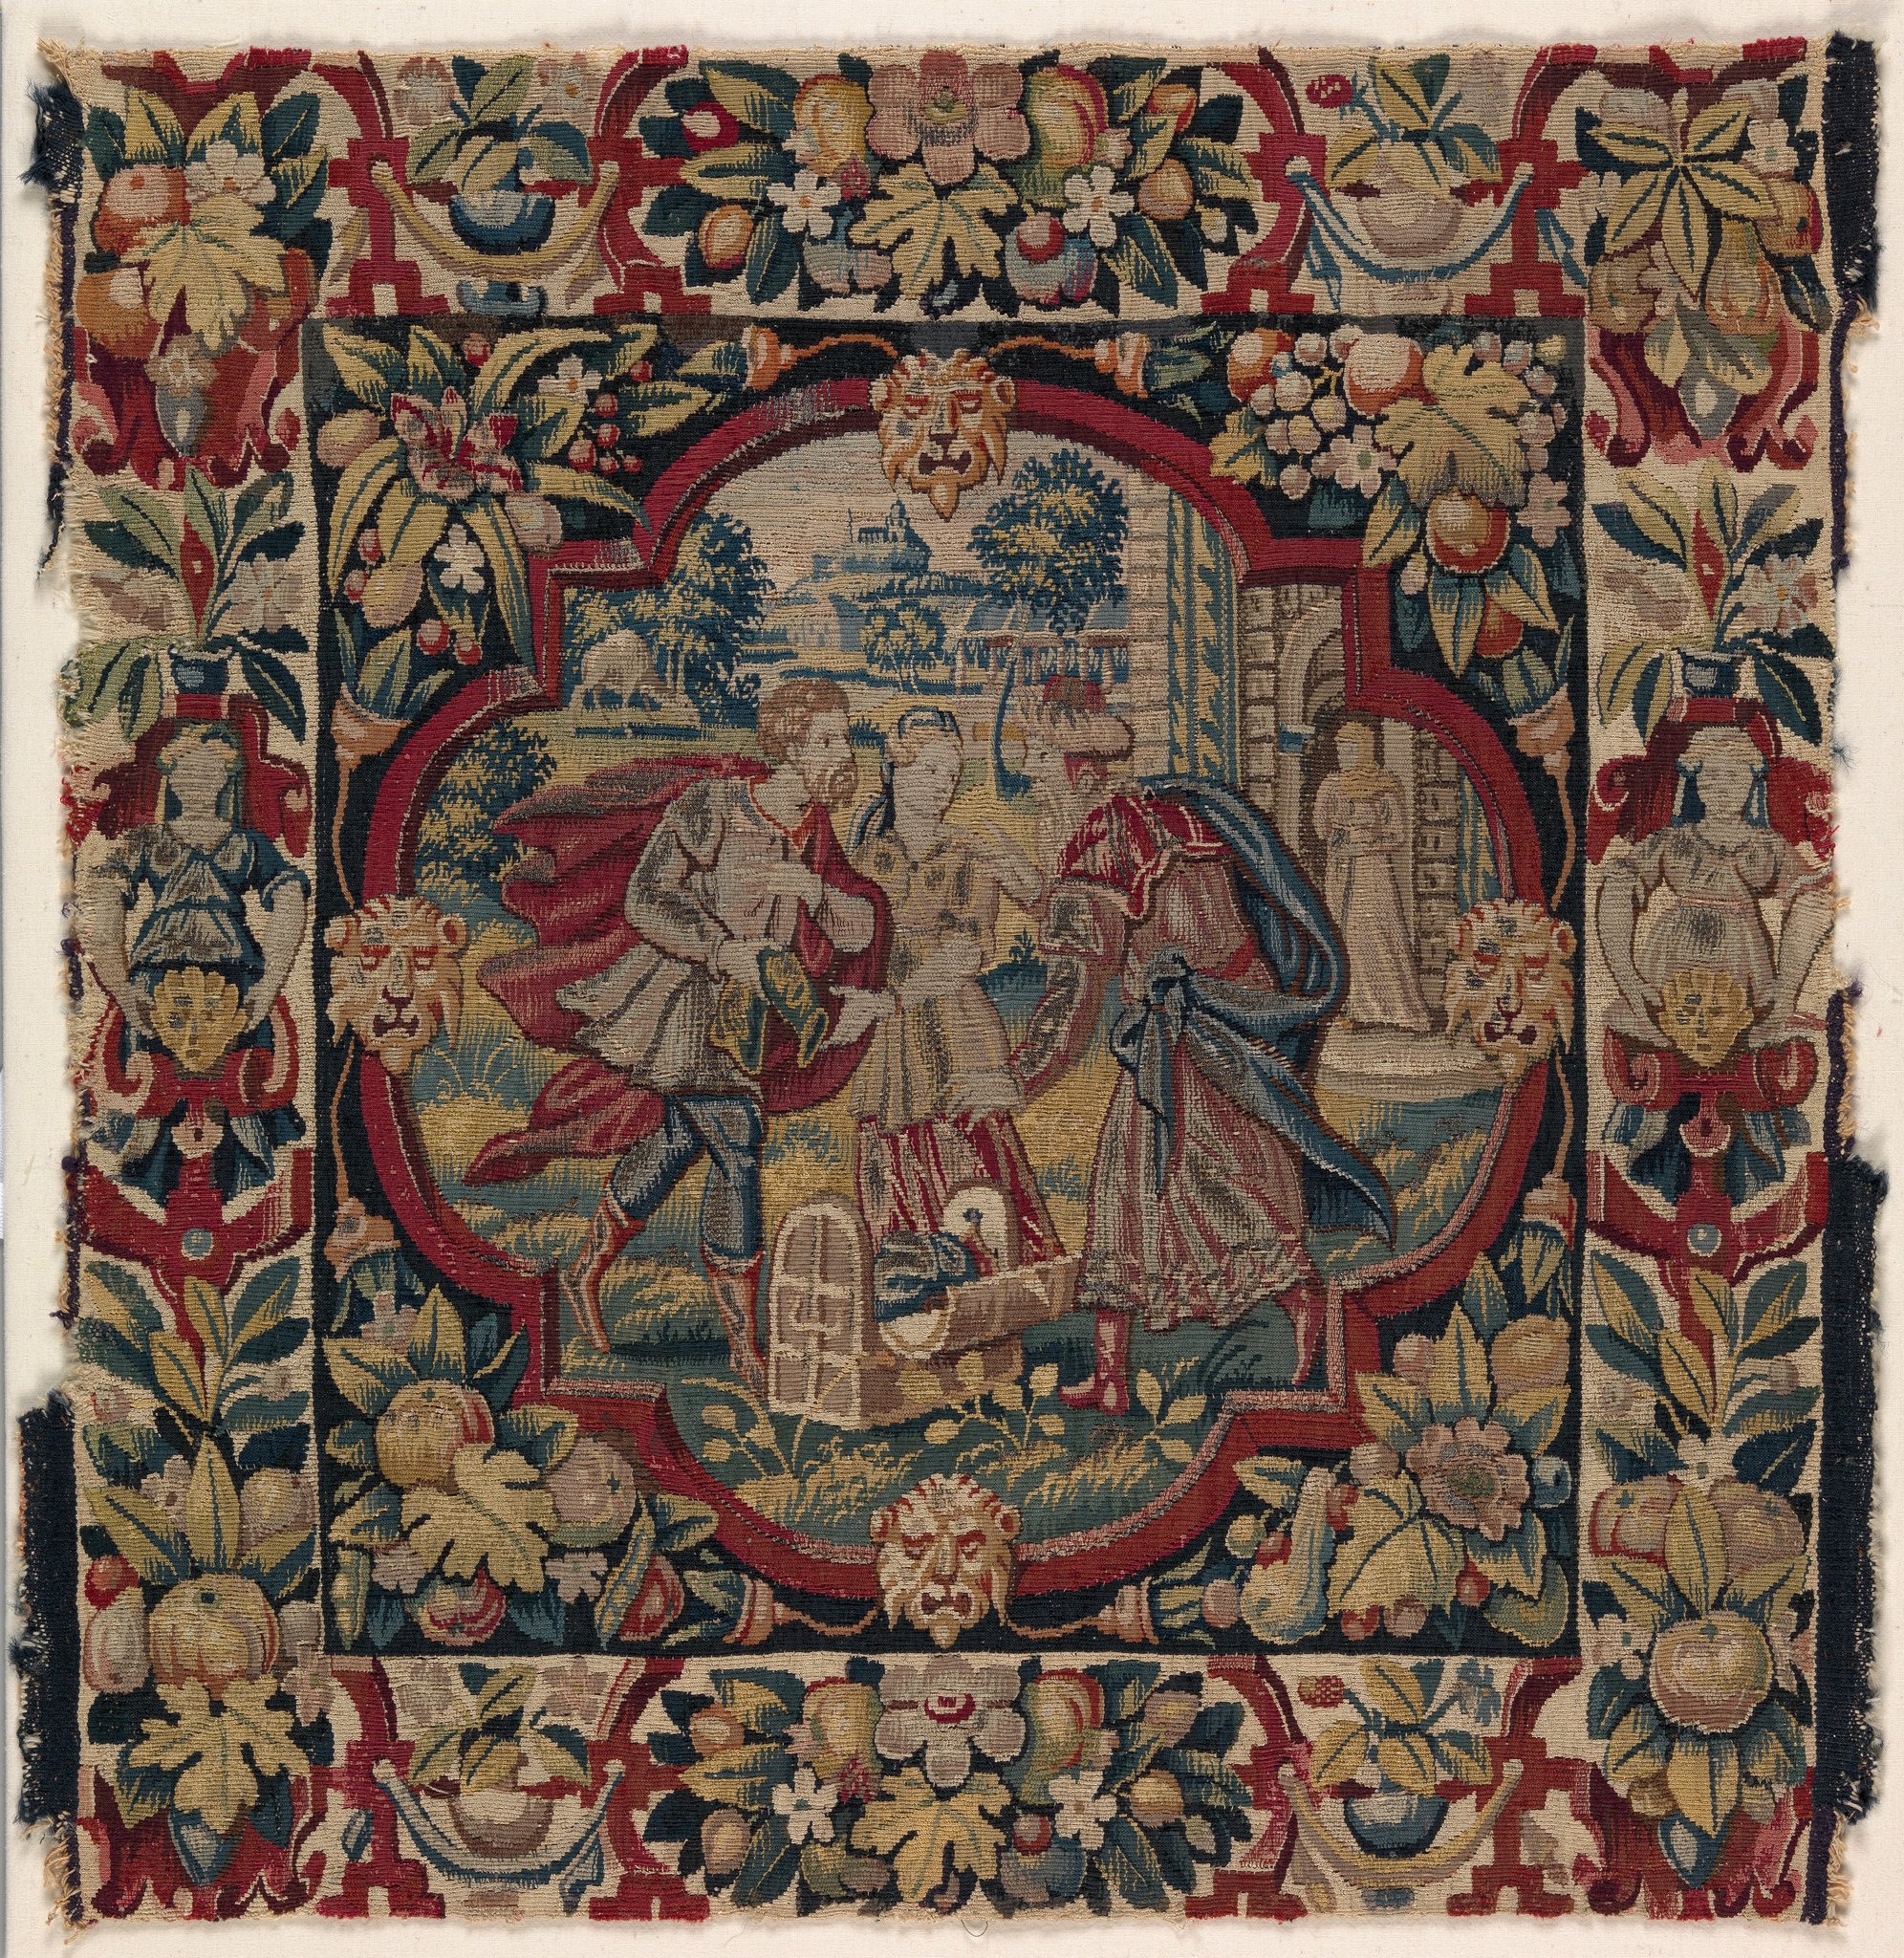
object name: cushion cover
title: Rebekah, Laban, and Eliezer from the Story of Abraham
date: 1600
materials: silk, silver gilt, thread, wool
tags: men,women,deer,abraham